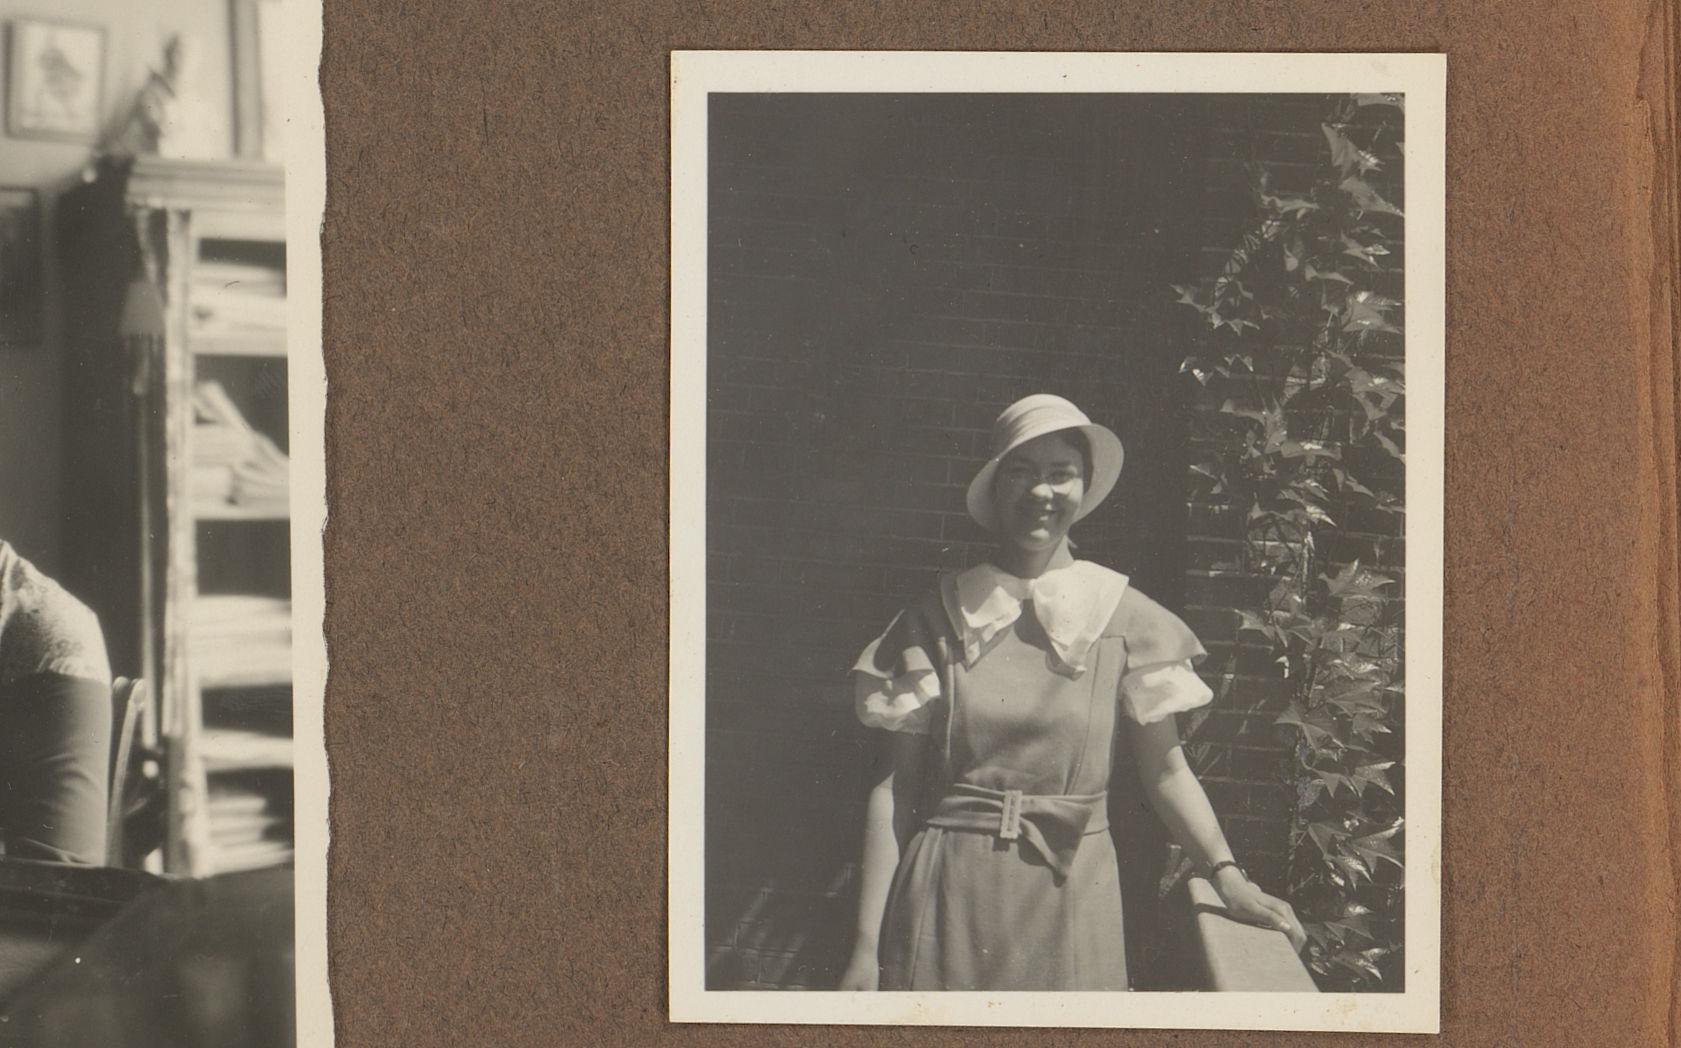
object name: photograph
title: Jonge vrouw met hoed bij klimop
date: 1900-1920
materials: photographic support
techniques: photography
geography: amsterdam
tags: netherlands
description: Foto op bruin albumblad 53 van familiealbum van Alphons Diepenbrock.